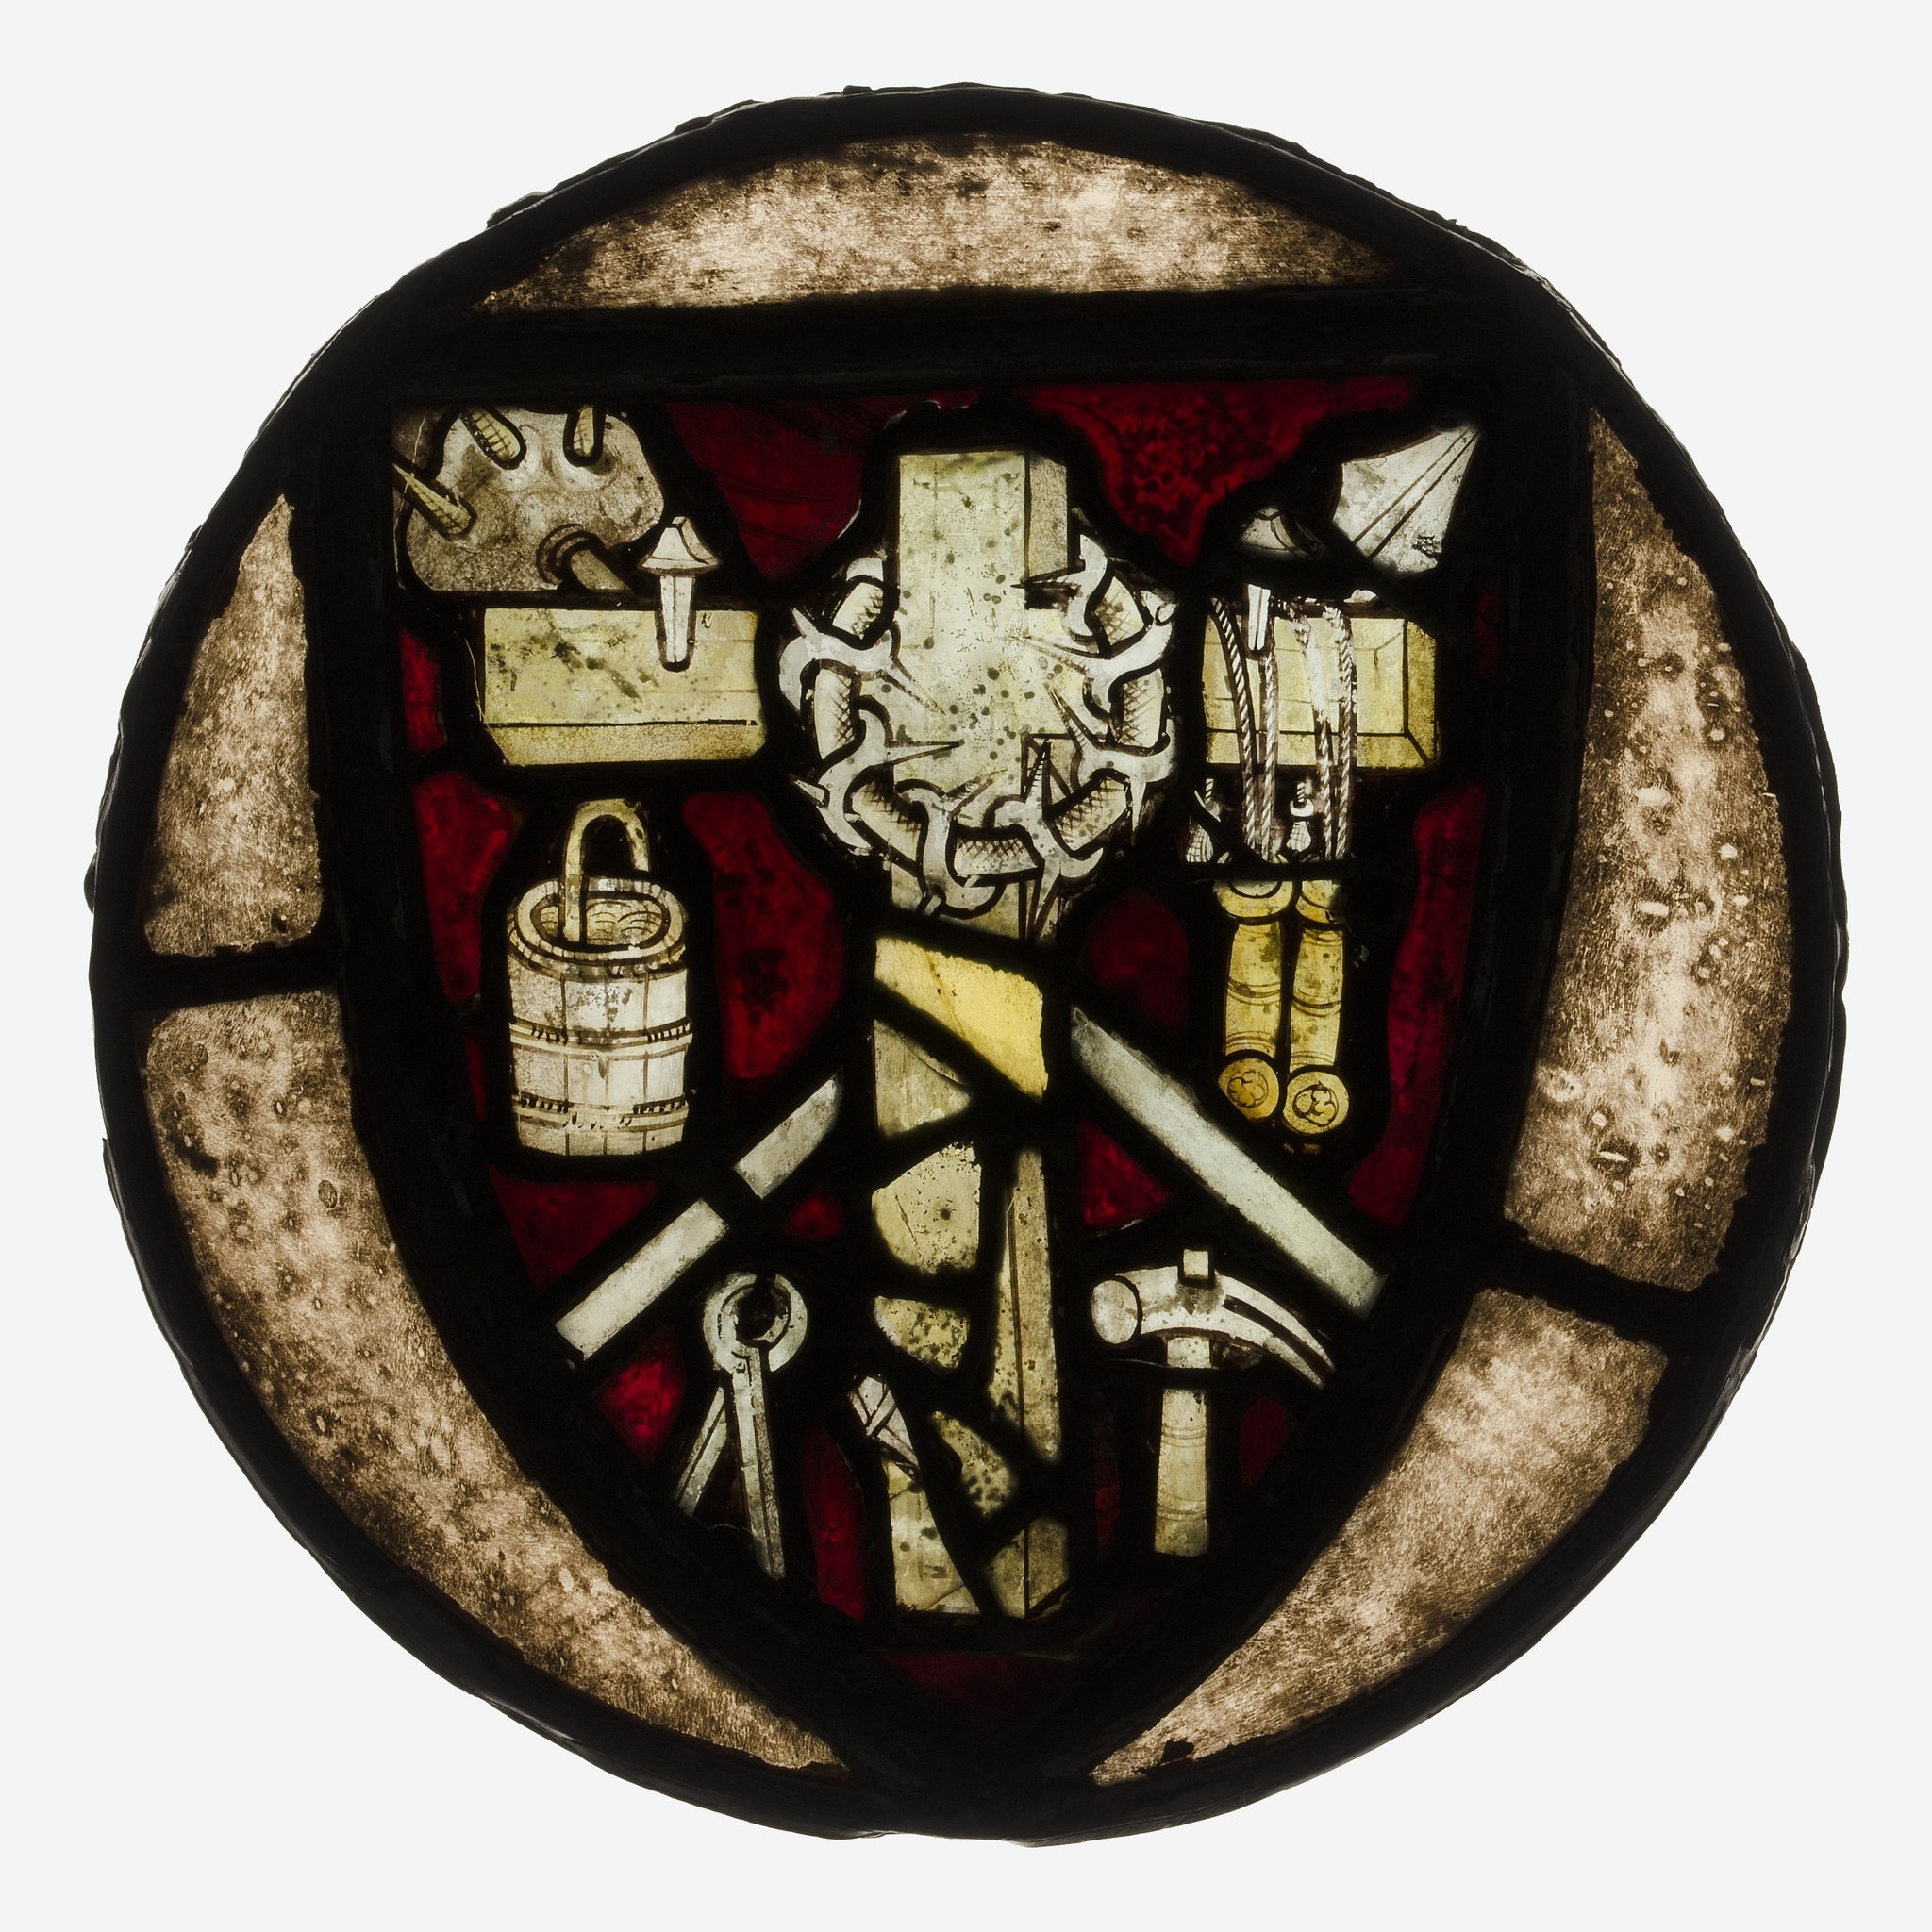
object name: roundel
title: Roundel with Intruments of the Passion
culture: british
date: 1401-1433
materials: glass, metal, paint